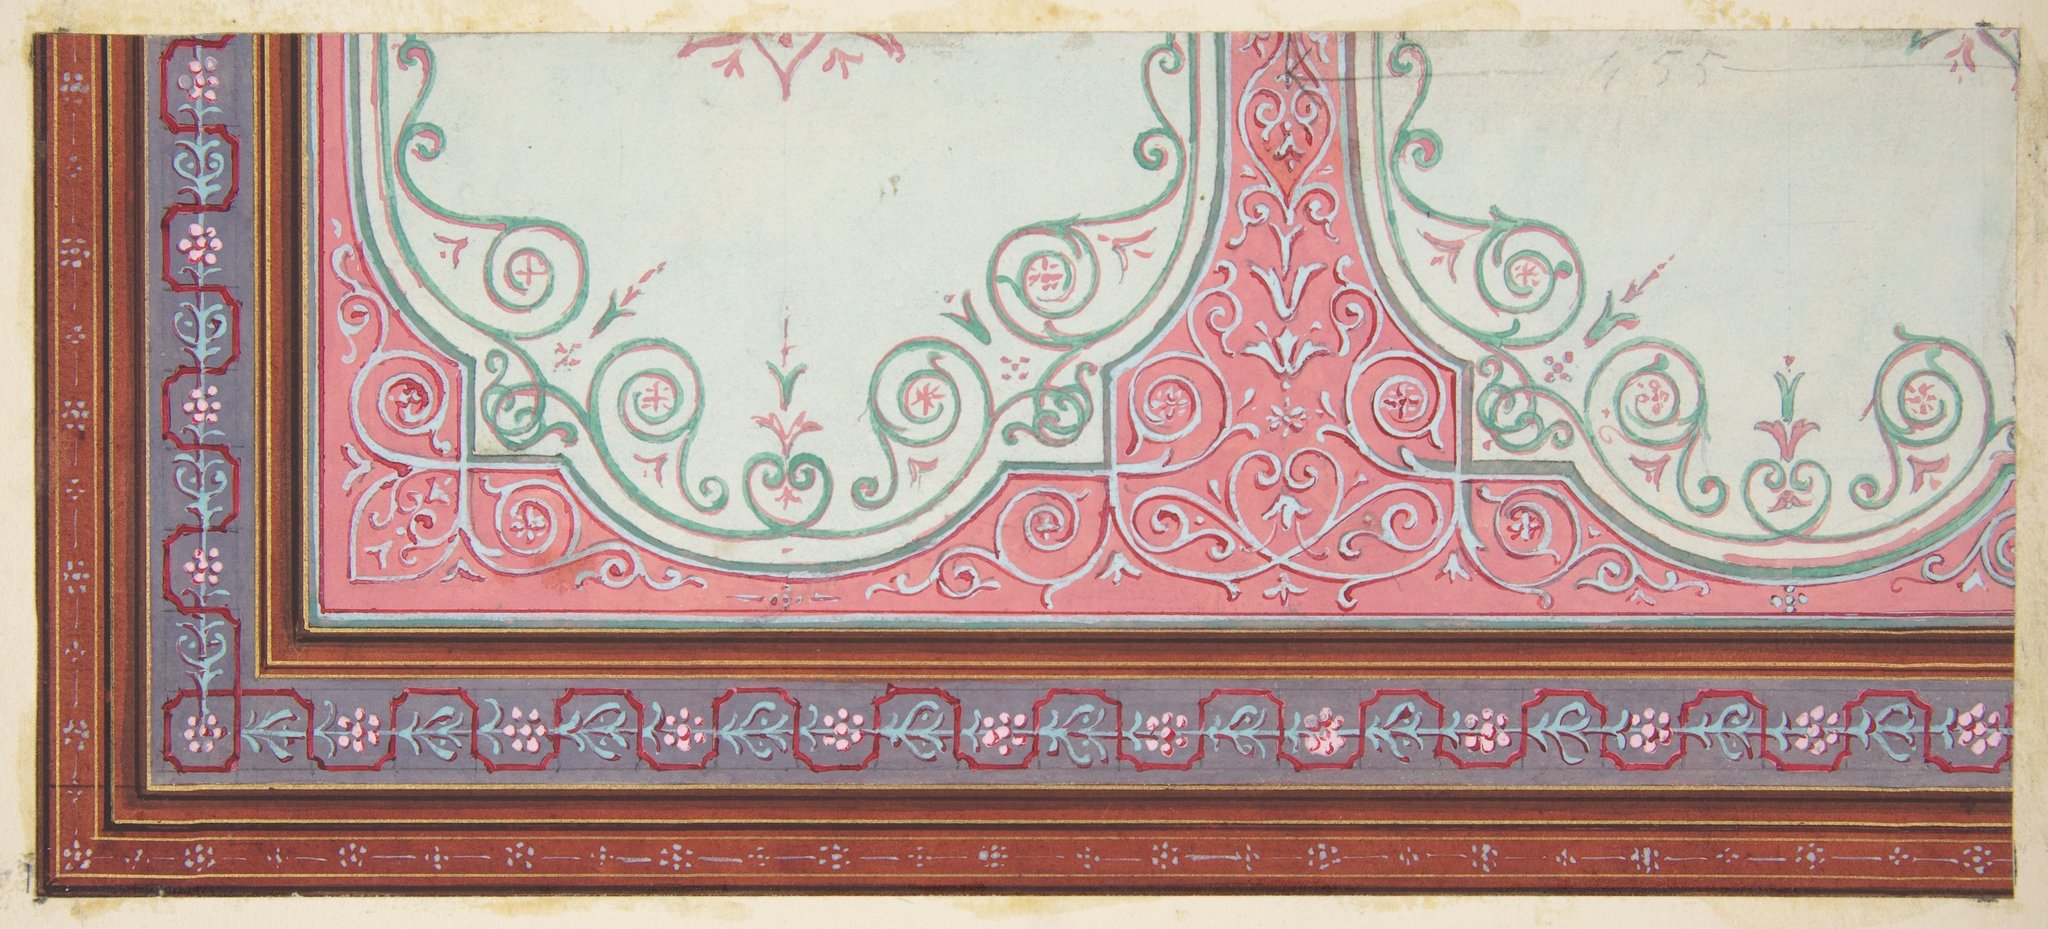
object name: drawing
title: Partial design for the decoration of a ceiling with scrollwork and a border of ribbons and berries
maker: jules-edmond-charles lachaise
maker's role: artist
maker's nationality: french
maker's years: 1897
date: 1830-1897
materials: gold paint, graphite, paper, watercolor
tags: ceilings